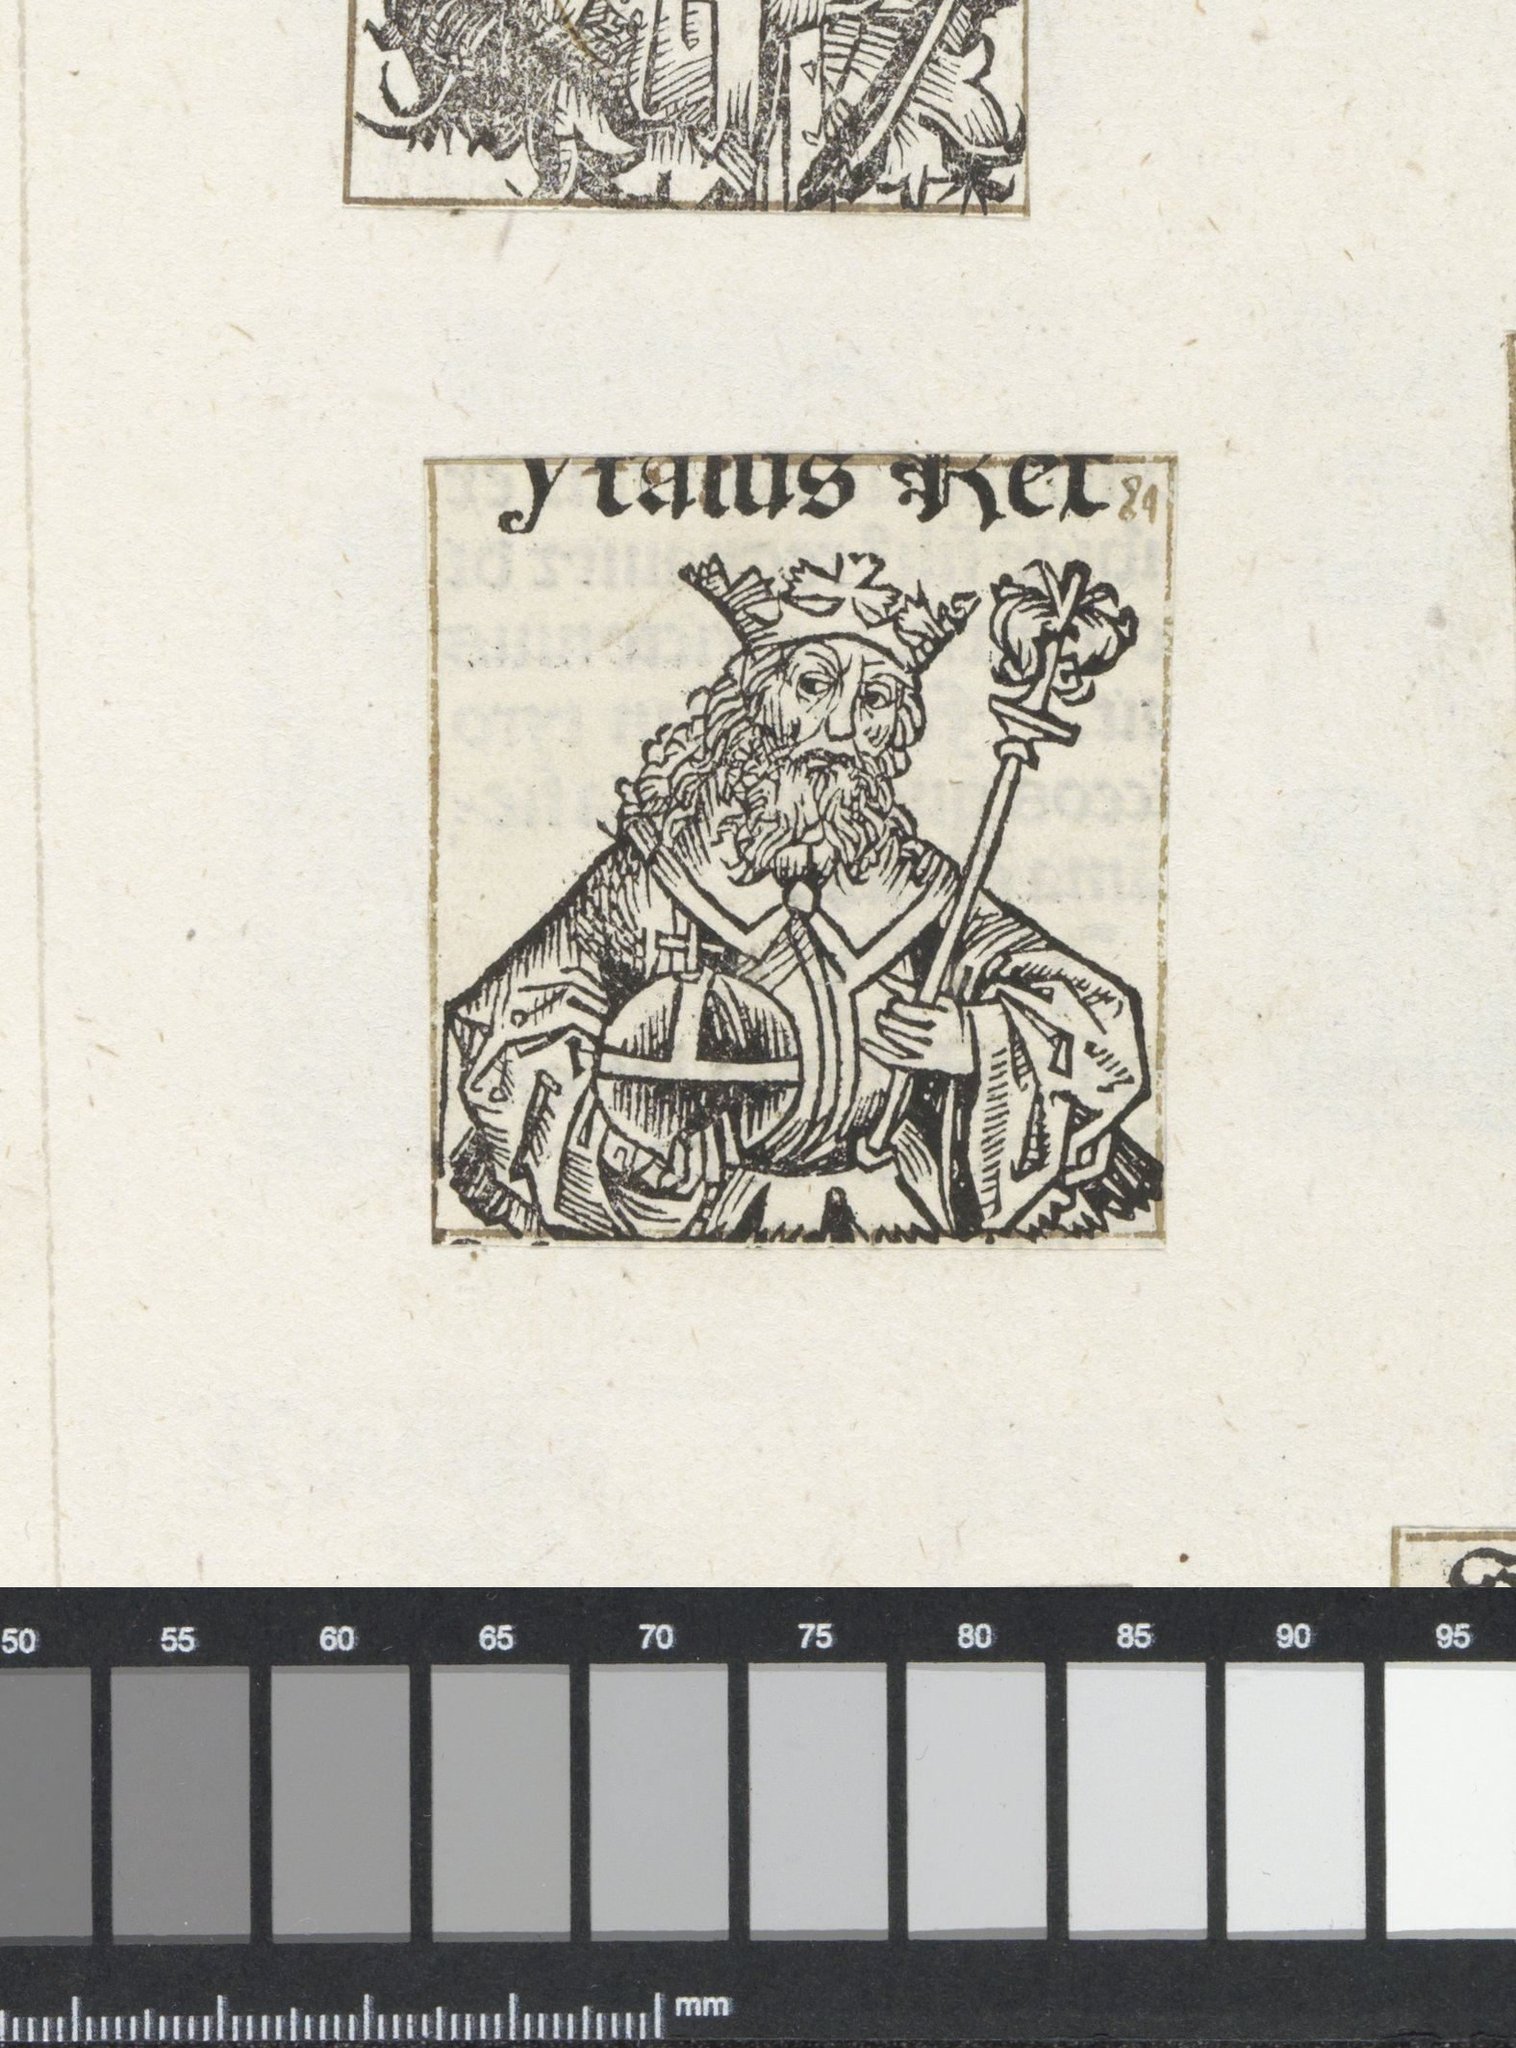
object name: album leaf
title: Ytalus Rex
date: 1493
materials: paper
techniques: letterpress printing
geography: nuremberg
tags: king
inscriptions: inscription: ‘84’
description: De houtsnede wordt gebruikt als boekillustratie in de Liber Chronicarum (of Neurenbergkroniek) van Hartmann Schedel, verschenen in het Latijn en Duits in 1493. Zie de Latijnse uitgave, folio 34v.